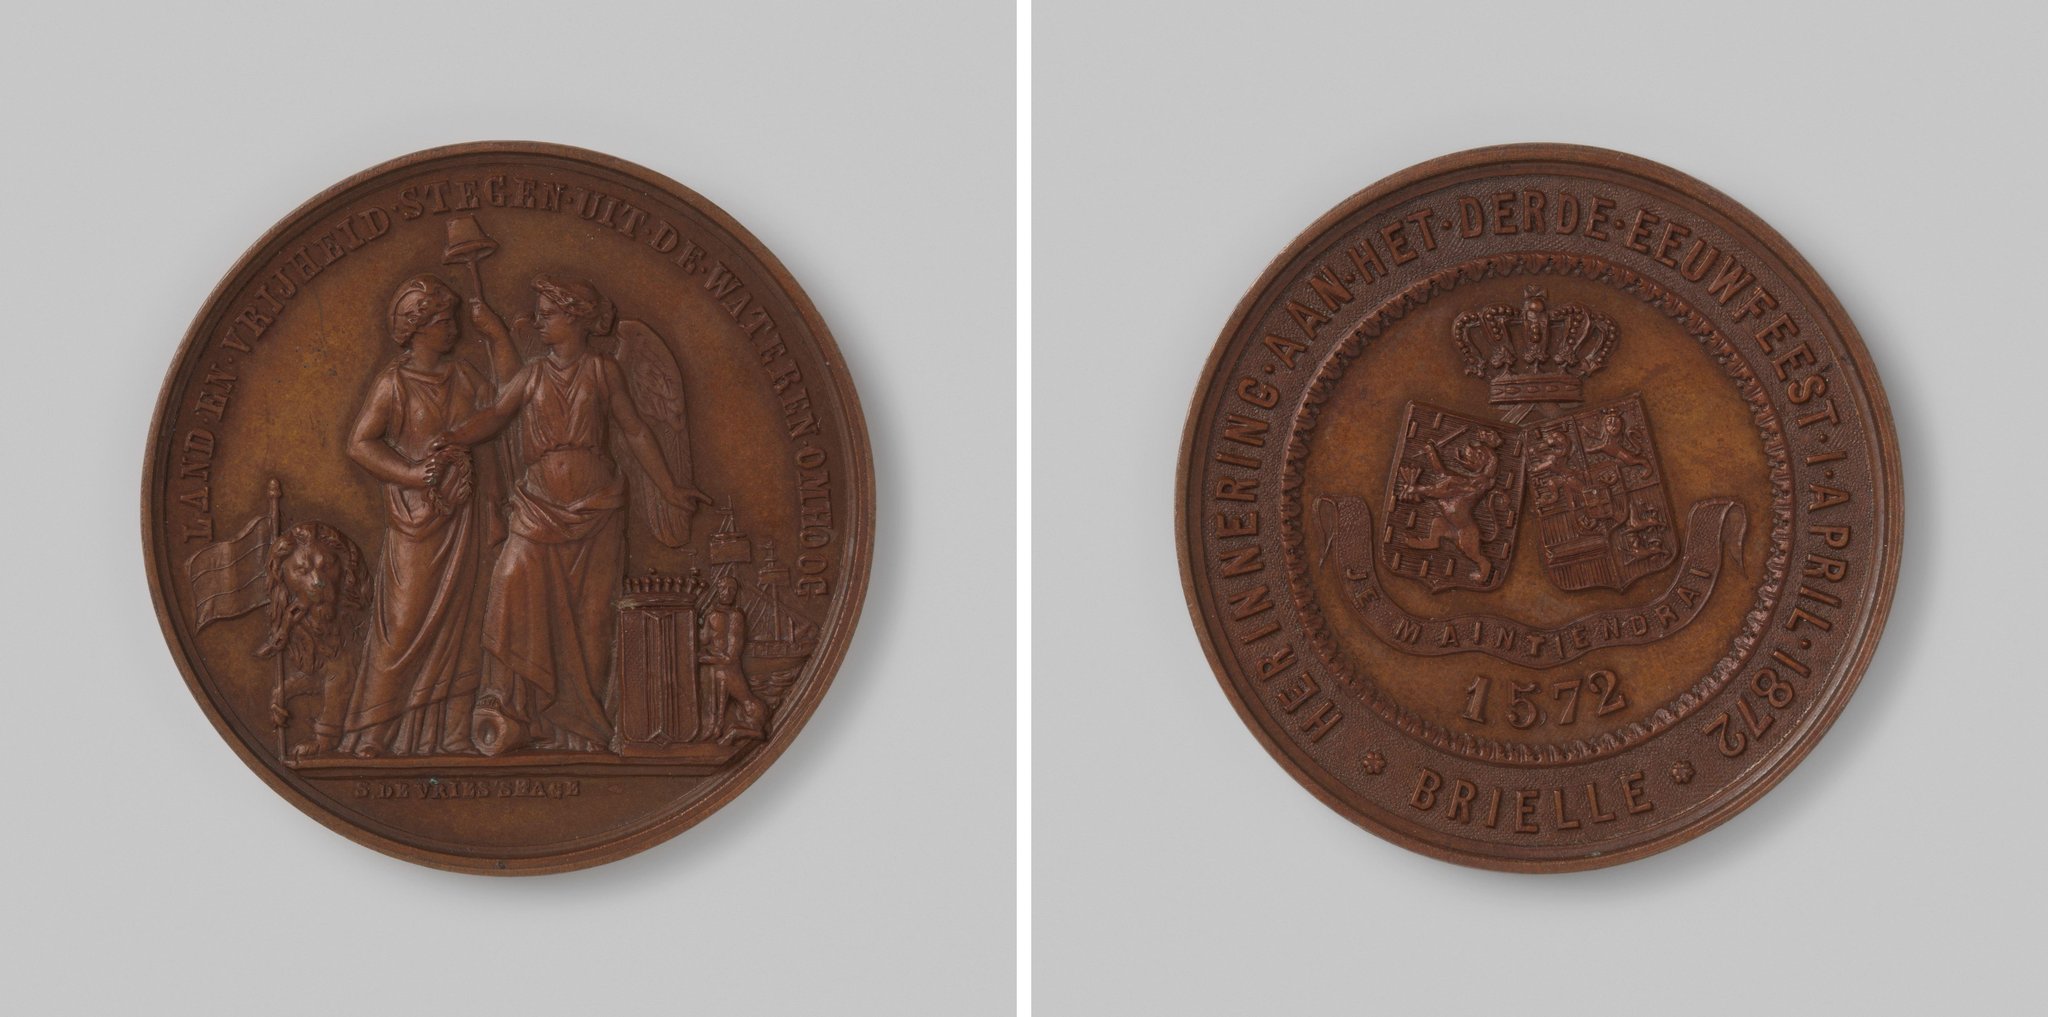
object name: medal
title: Herdenking van de inname van Den Briel 1872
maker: salomon de vries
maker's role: graveur, medailleur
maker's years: 1830-1899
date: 1872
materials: bronze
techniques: striking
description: Bronzen penning: op de voorzijde de Nederlandse Maagd met lans met vrijheidshoed ontvangt een lauwerkrans van Victoria, met links de Nederlandse Leeuw, rechts een watergeus en het Brielse wapenschild, met omschrift, op de keerzijde onder één kroon de wapenschilden van Nederland en Oranje, waaronder een tekstlint en het jaartal 1572, met omschrift.